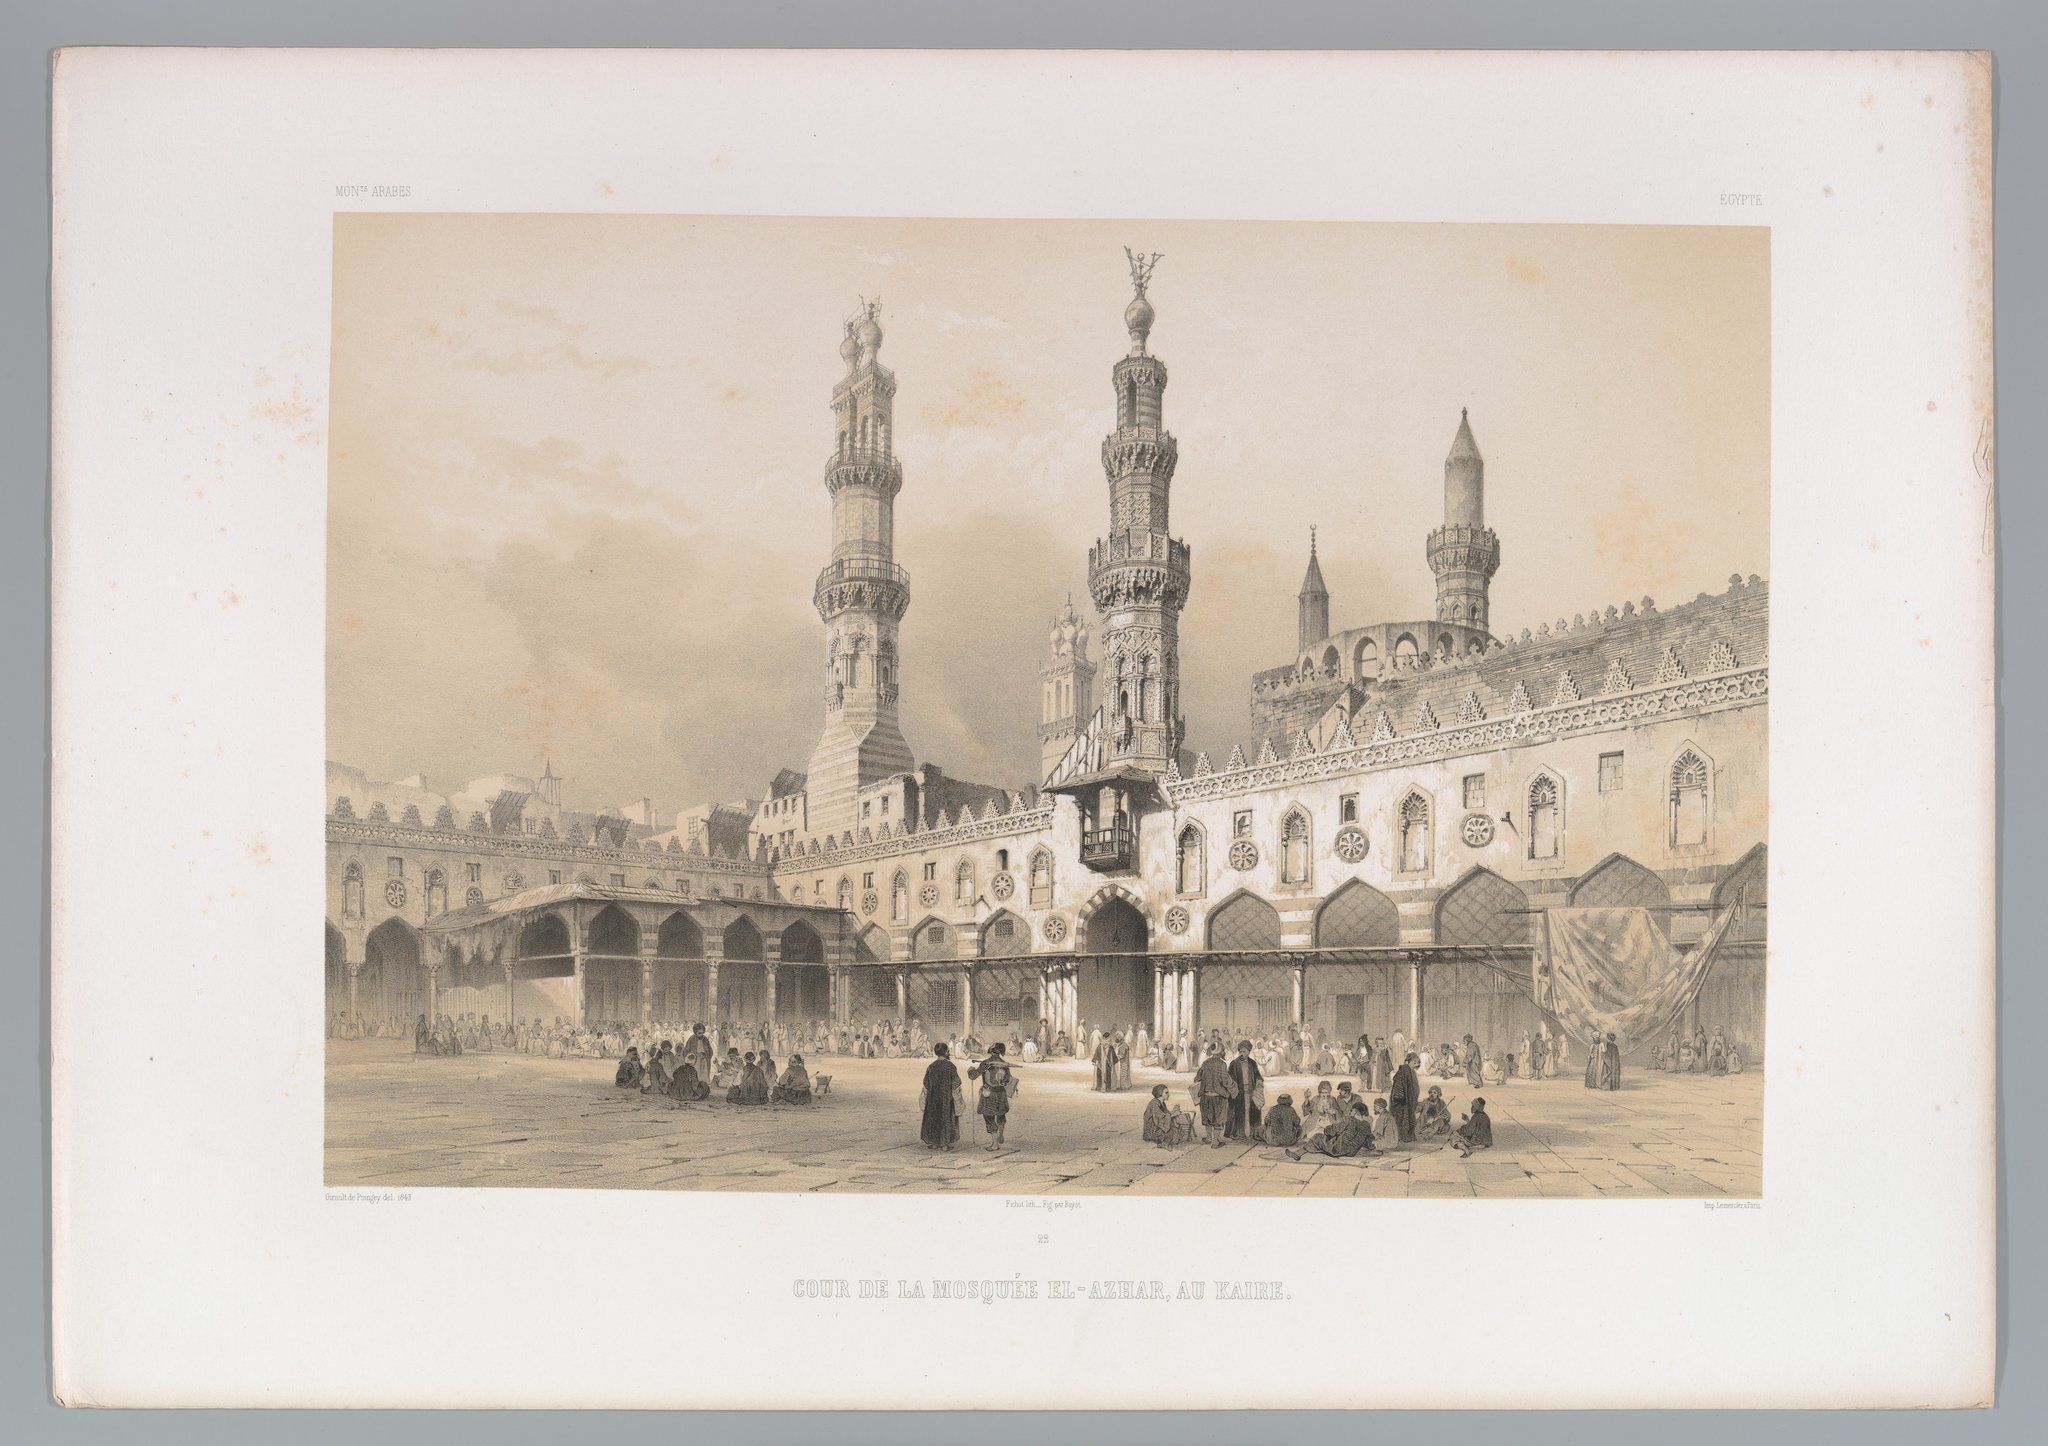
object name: lithograph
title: 22. Cour de la Mosquée el Ahzar, au Kaire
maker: joseph-philibert girault de prangey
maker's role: artist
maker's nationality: french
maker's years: 1804-1892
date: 1843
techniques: lithograph